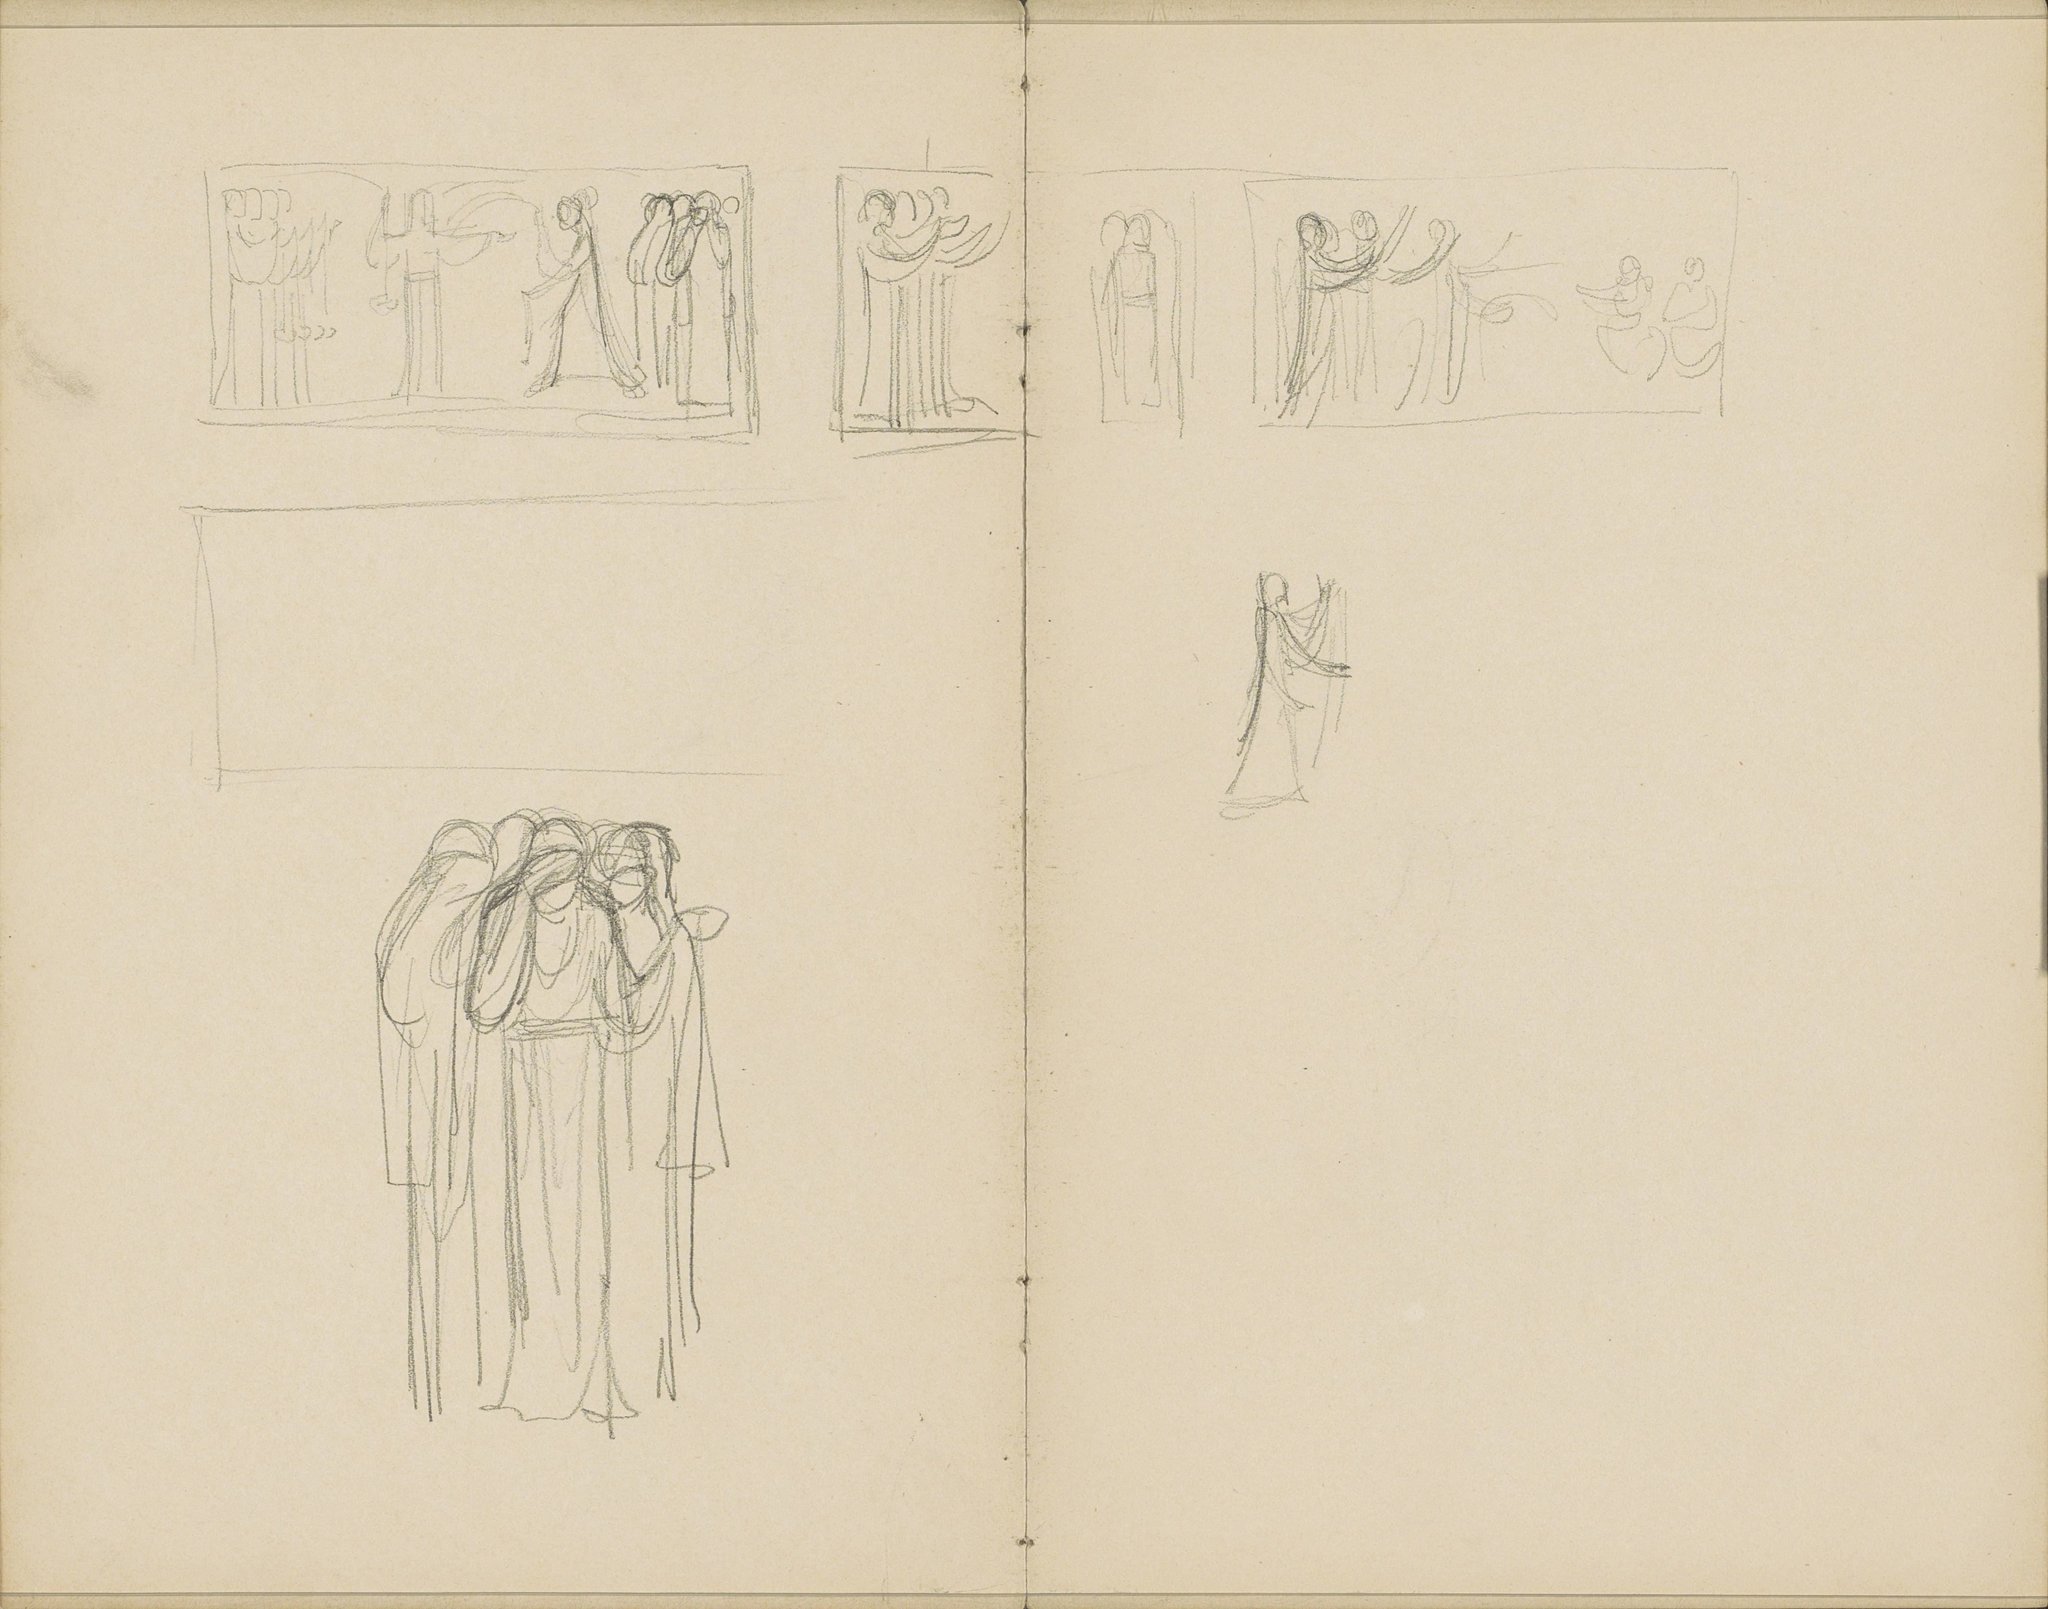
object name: sketchbook leaf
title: Ontwerp voor een wandschildering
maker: antoon derkinderen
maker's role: draughtsman, painter, print maker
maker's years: 1859-1925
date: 1889-1891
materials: paper, pencil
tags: standing figure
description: Ontwerp met figuren in gewaden in verschillende houdingen. Mogelijk een voorstudie voor Derkinderens wandschildering in het stadhuis te Den Bosch. Blad 26 verso en 27 recto uit een schetsboek met 33 bladen.